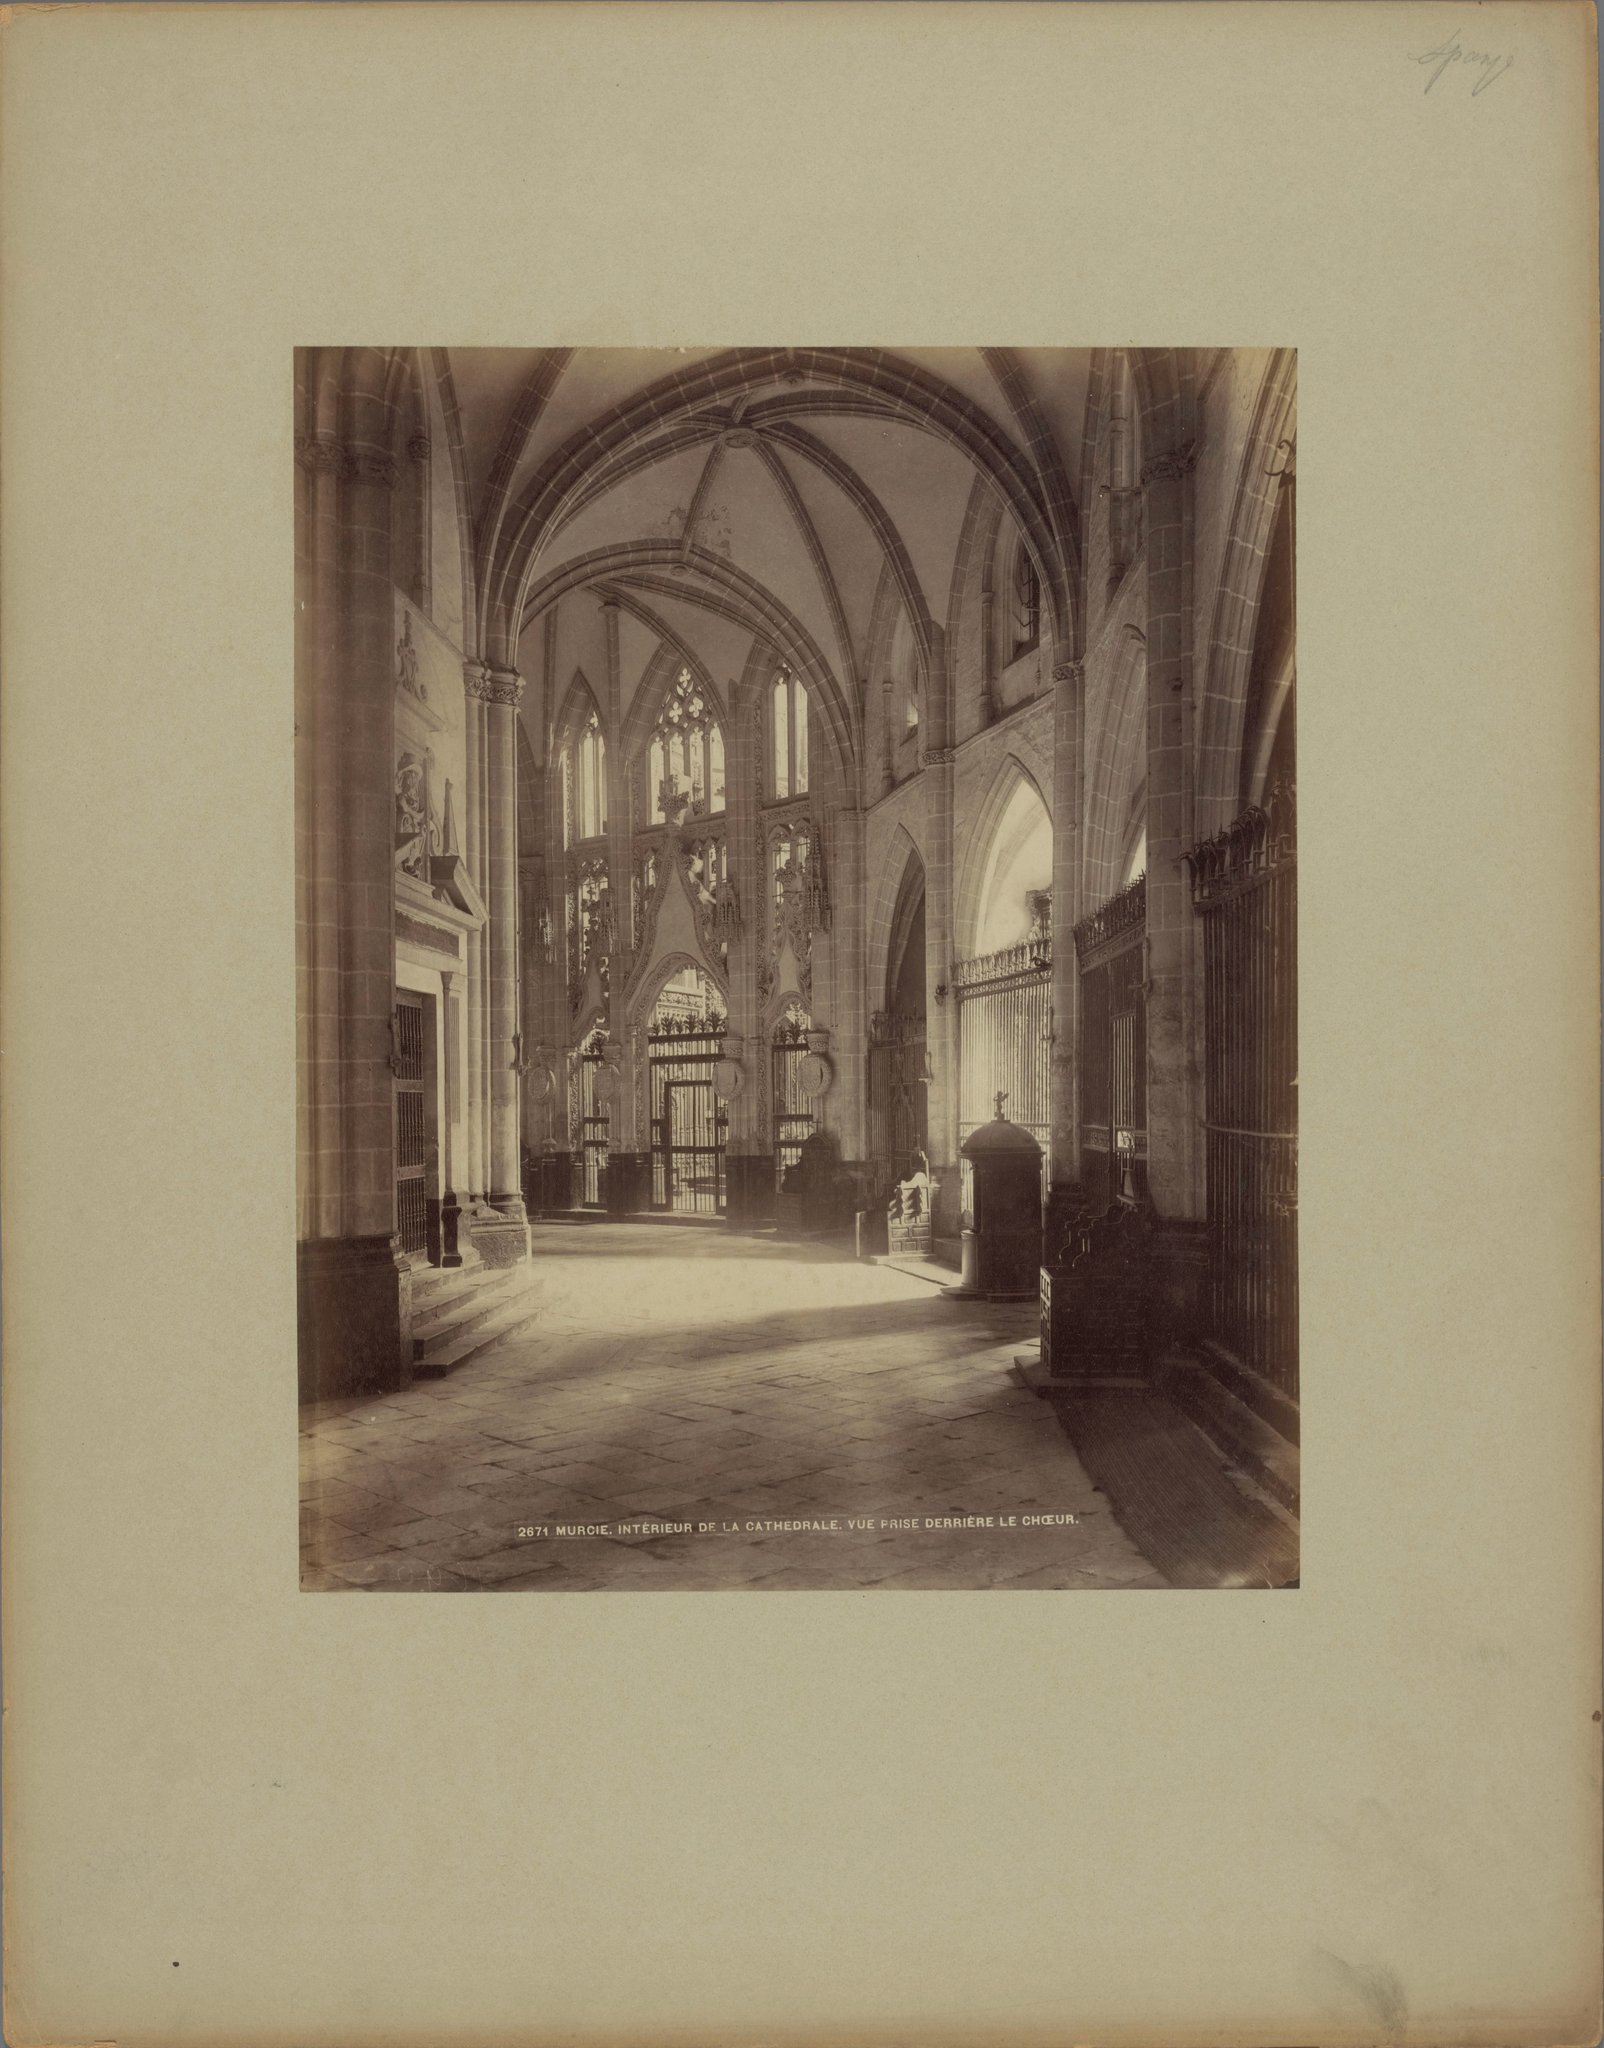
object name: photograph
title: Burgos. - Int. de la Cathédrale [(...)]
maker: Anonymous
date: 1875-1900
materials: cardboard, photographic support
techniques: albumen print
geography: burgos cathedral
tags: parts of church interior: vault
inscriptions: collector's mark: Lugt 3937, number: ‘958’